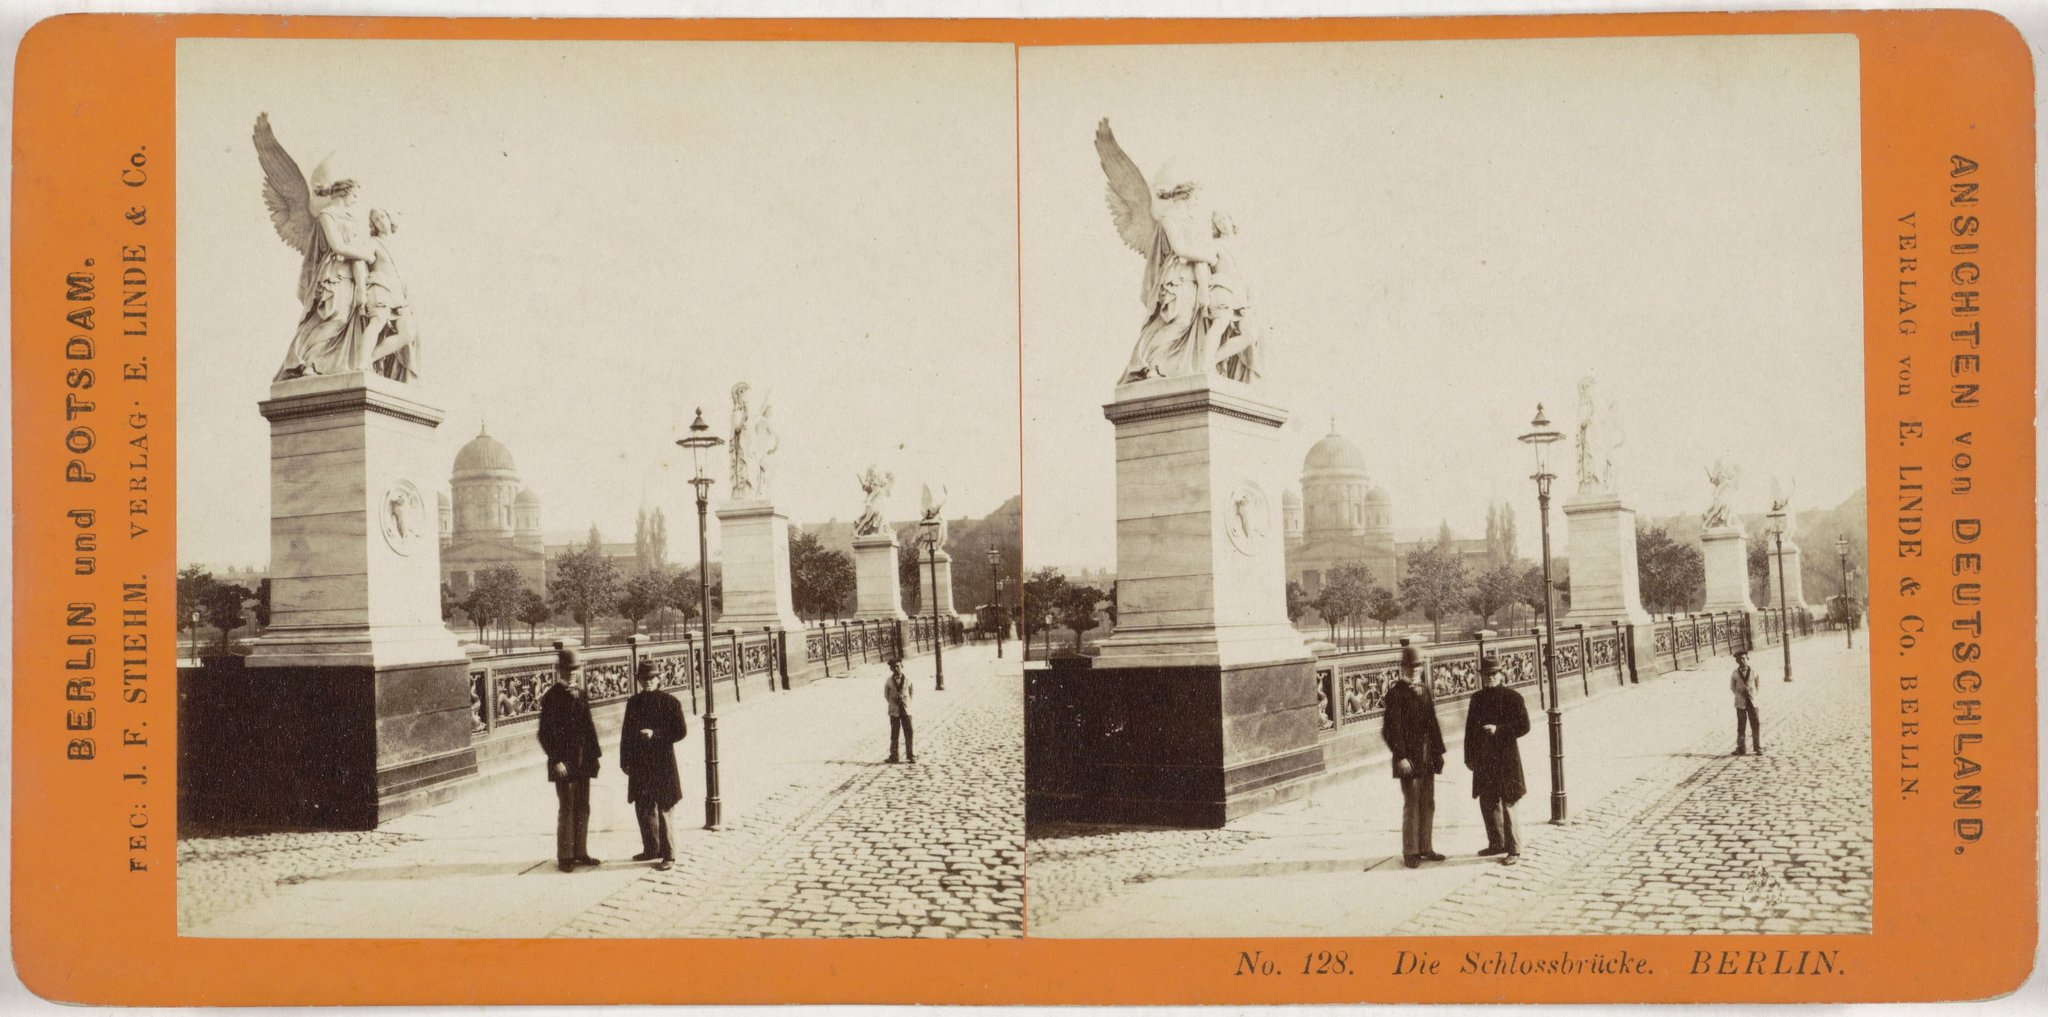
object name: stereograph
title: Schlossbrücke in Berlijn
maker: johann friedrich stiehm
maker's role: fotograaf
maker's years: 1826-1902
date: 1868-1870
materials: cardboard, paper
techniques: albumen print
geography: berlin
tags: sculpture, bridge, berlin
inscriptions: number: ‘No. 128.’